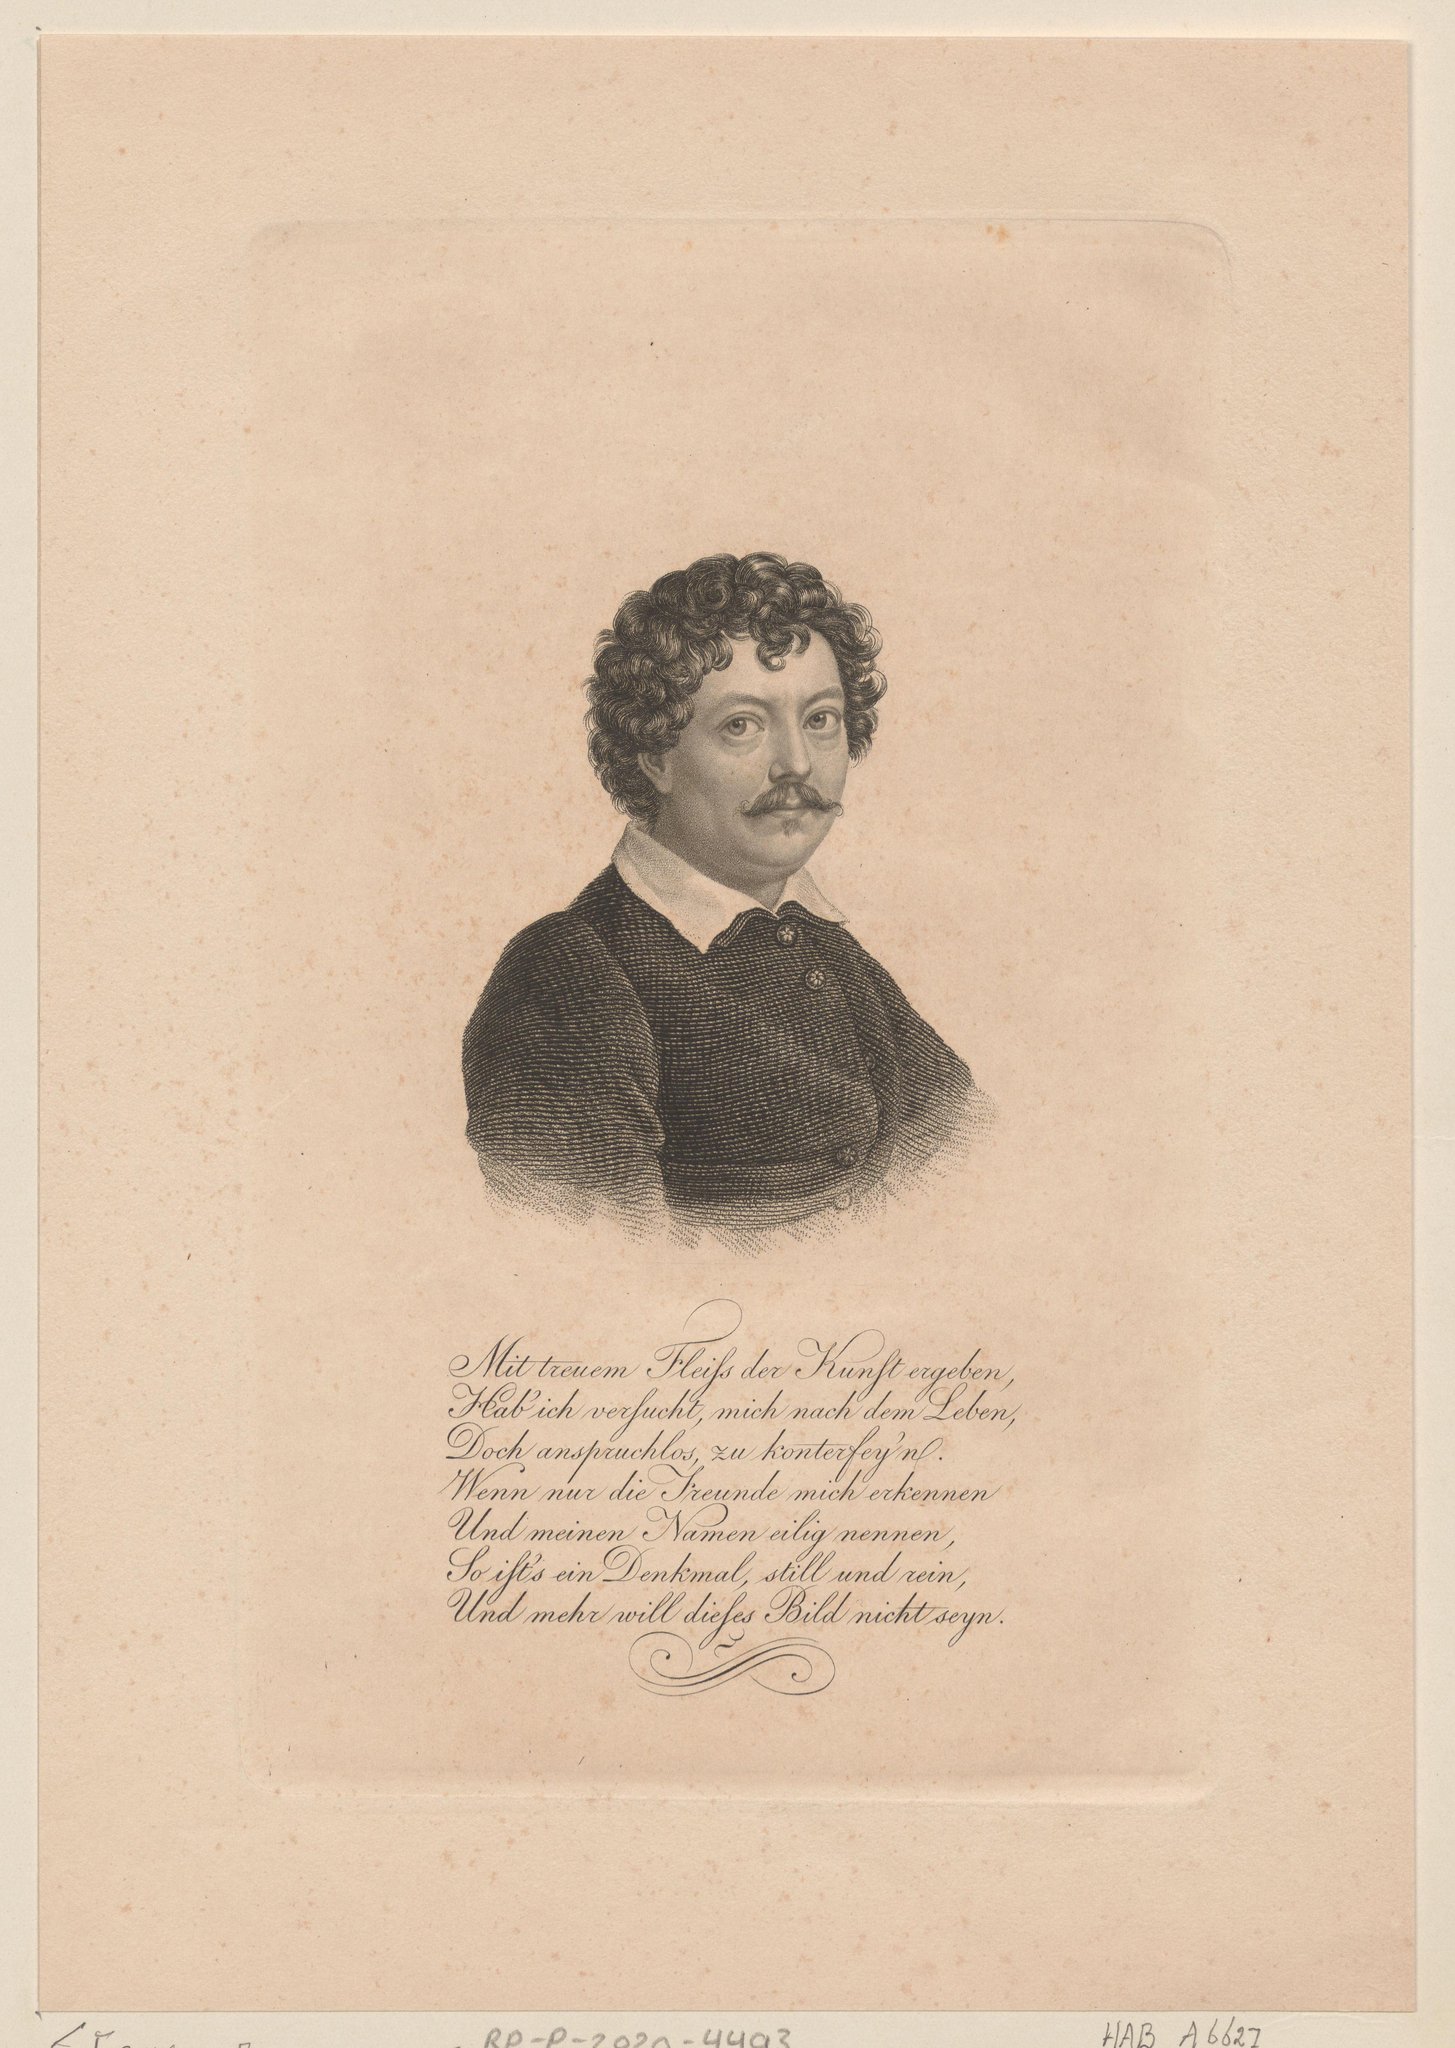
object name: print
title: Zelfportret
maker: friedrich fleischmann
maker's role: print maker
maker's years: 1791-1834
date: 1810-1834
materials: paper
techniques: engraving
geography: germany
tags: print maker, friedrich fleischmann, historical persons, portrait, self-portrait of graphic artist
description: Met zevenregelig vers in het Duits onder het portret.